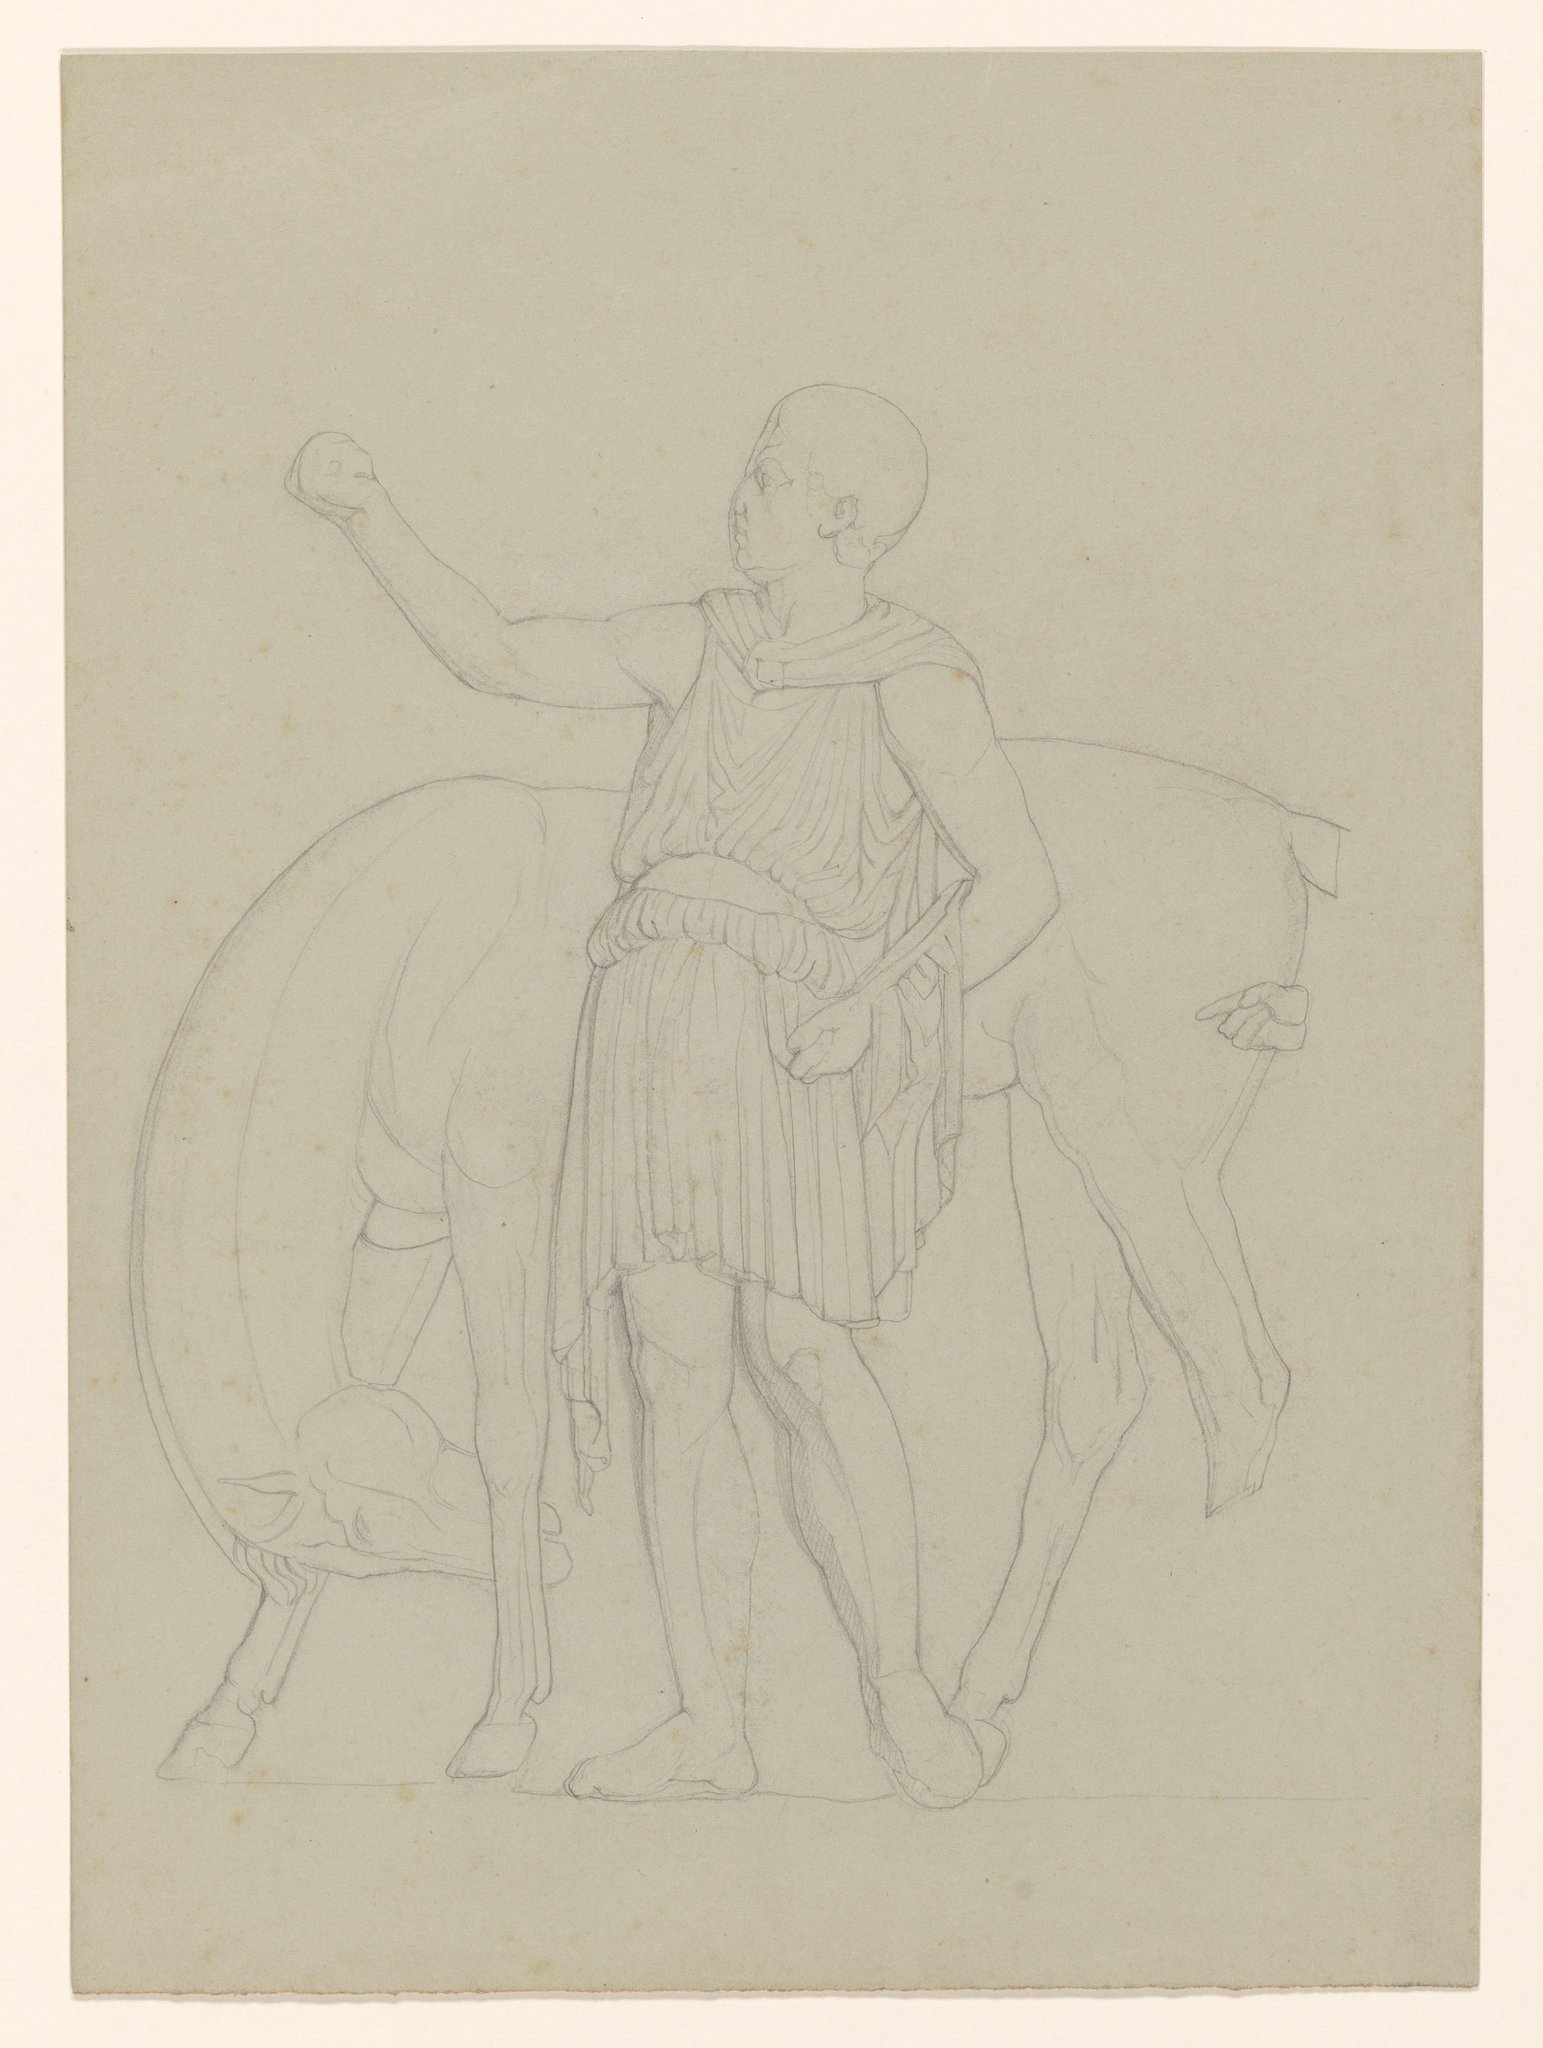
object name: drawing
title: Man en paard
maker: johan michaël schmidt crans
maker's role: draughtsman, print maker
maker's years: 1830-1907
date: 1840-1907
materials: paper, pencil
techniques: brush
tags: piece of sculpture, reproduction of a piece of sculpture (+ roman art)